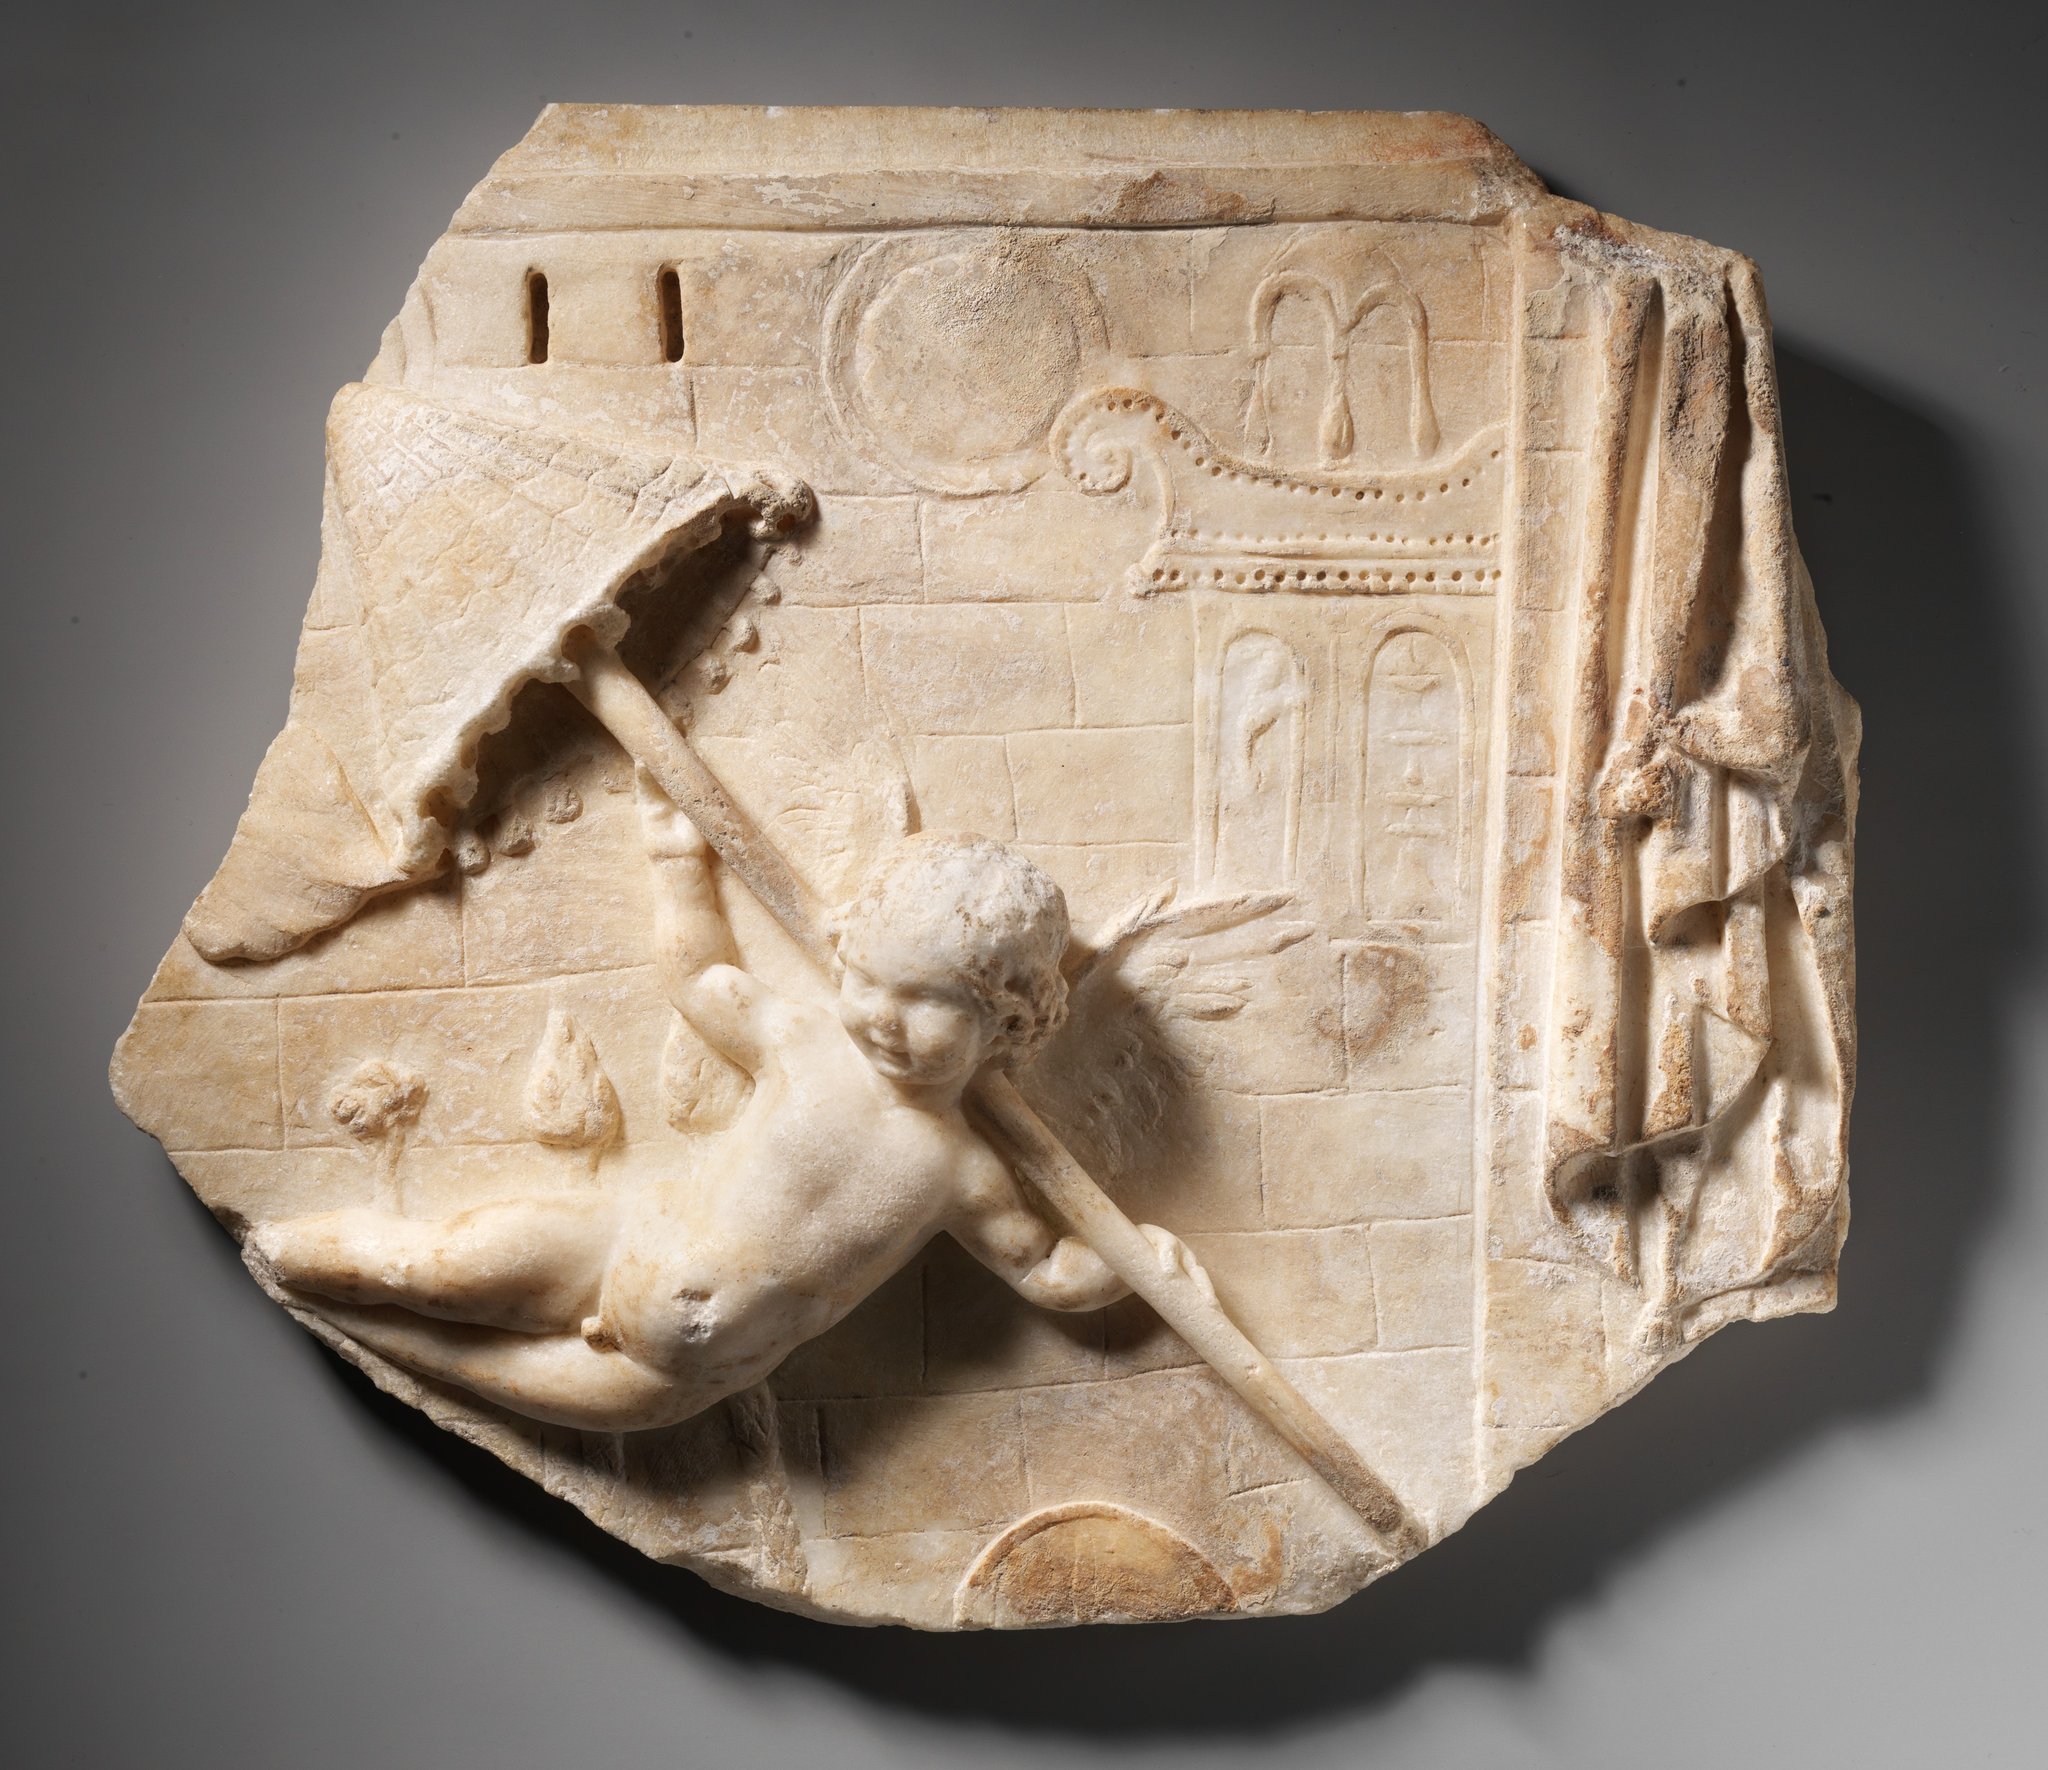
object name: relief fragment with eros carrying parasol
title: Marble fragment of a relief with a flying Eros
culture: roman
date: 1-100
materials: marble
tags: eros